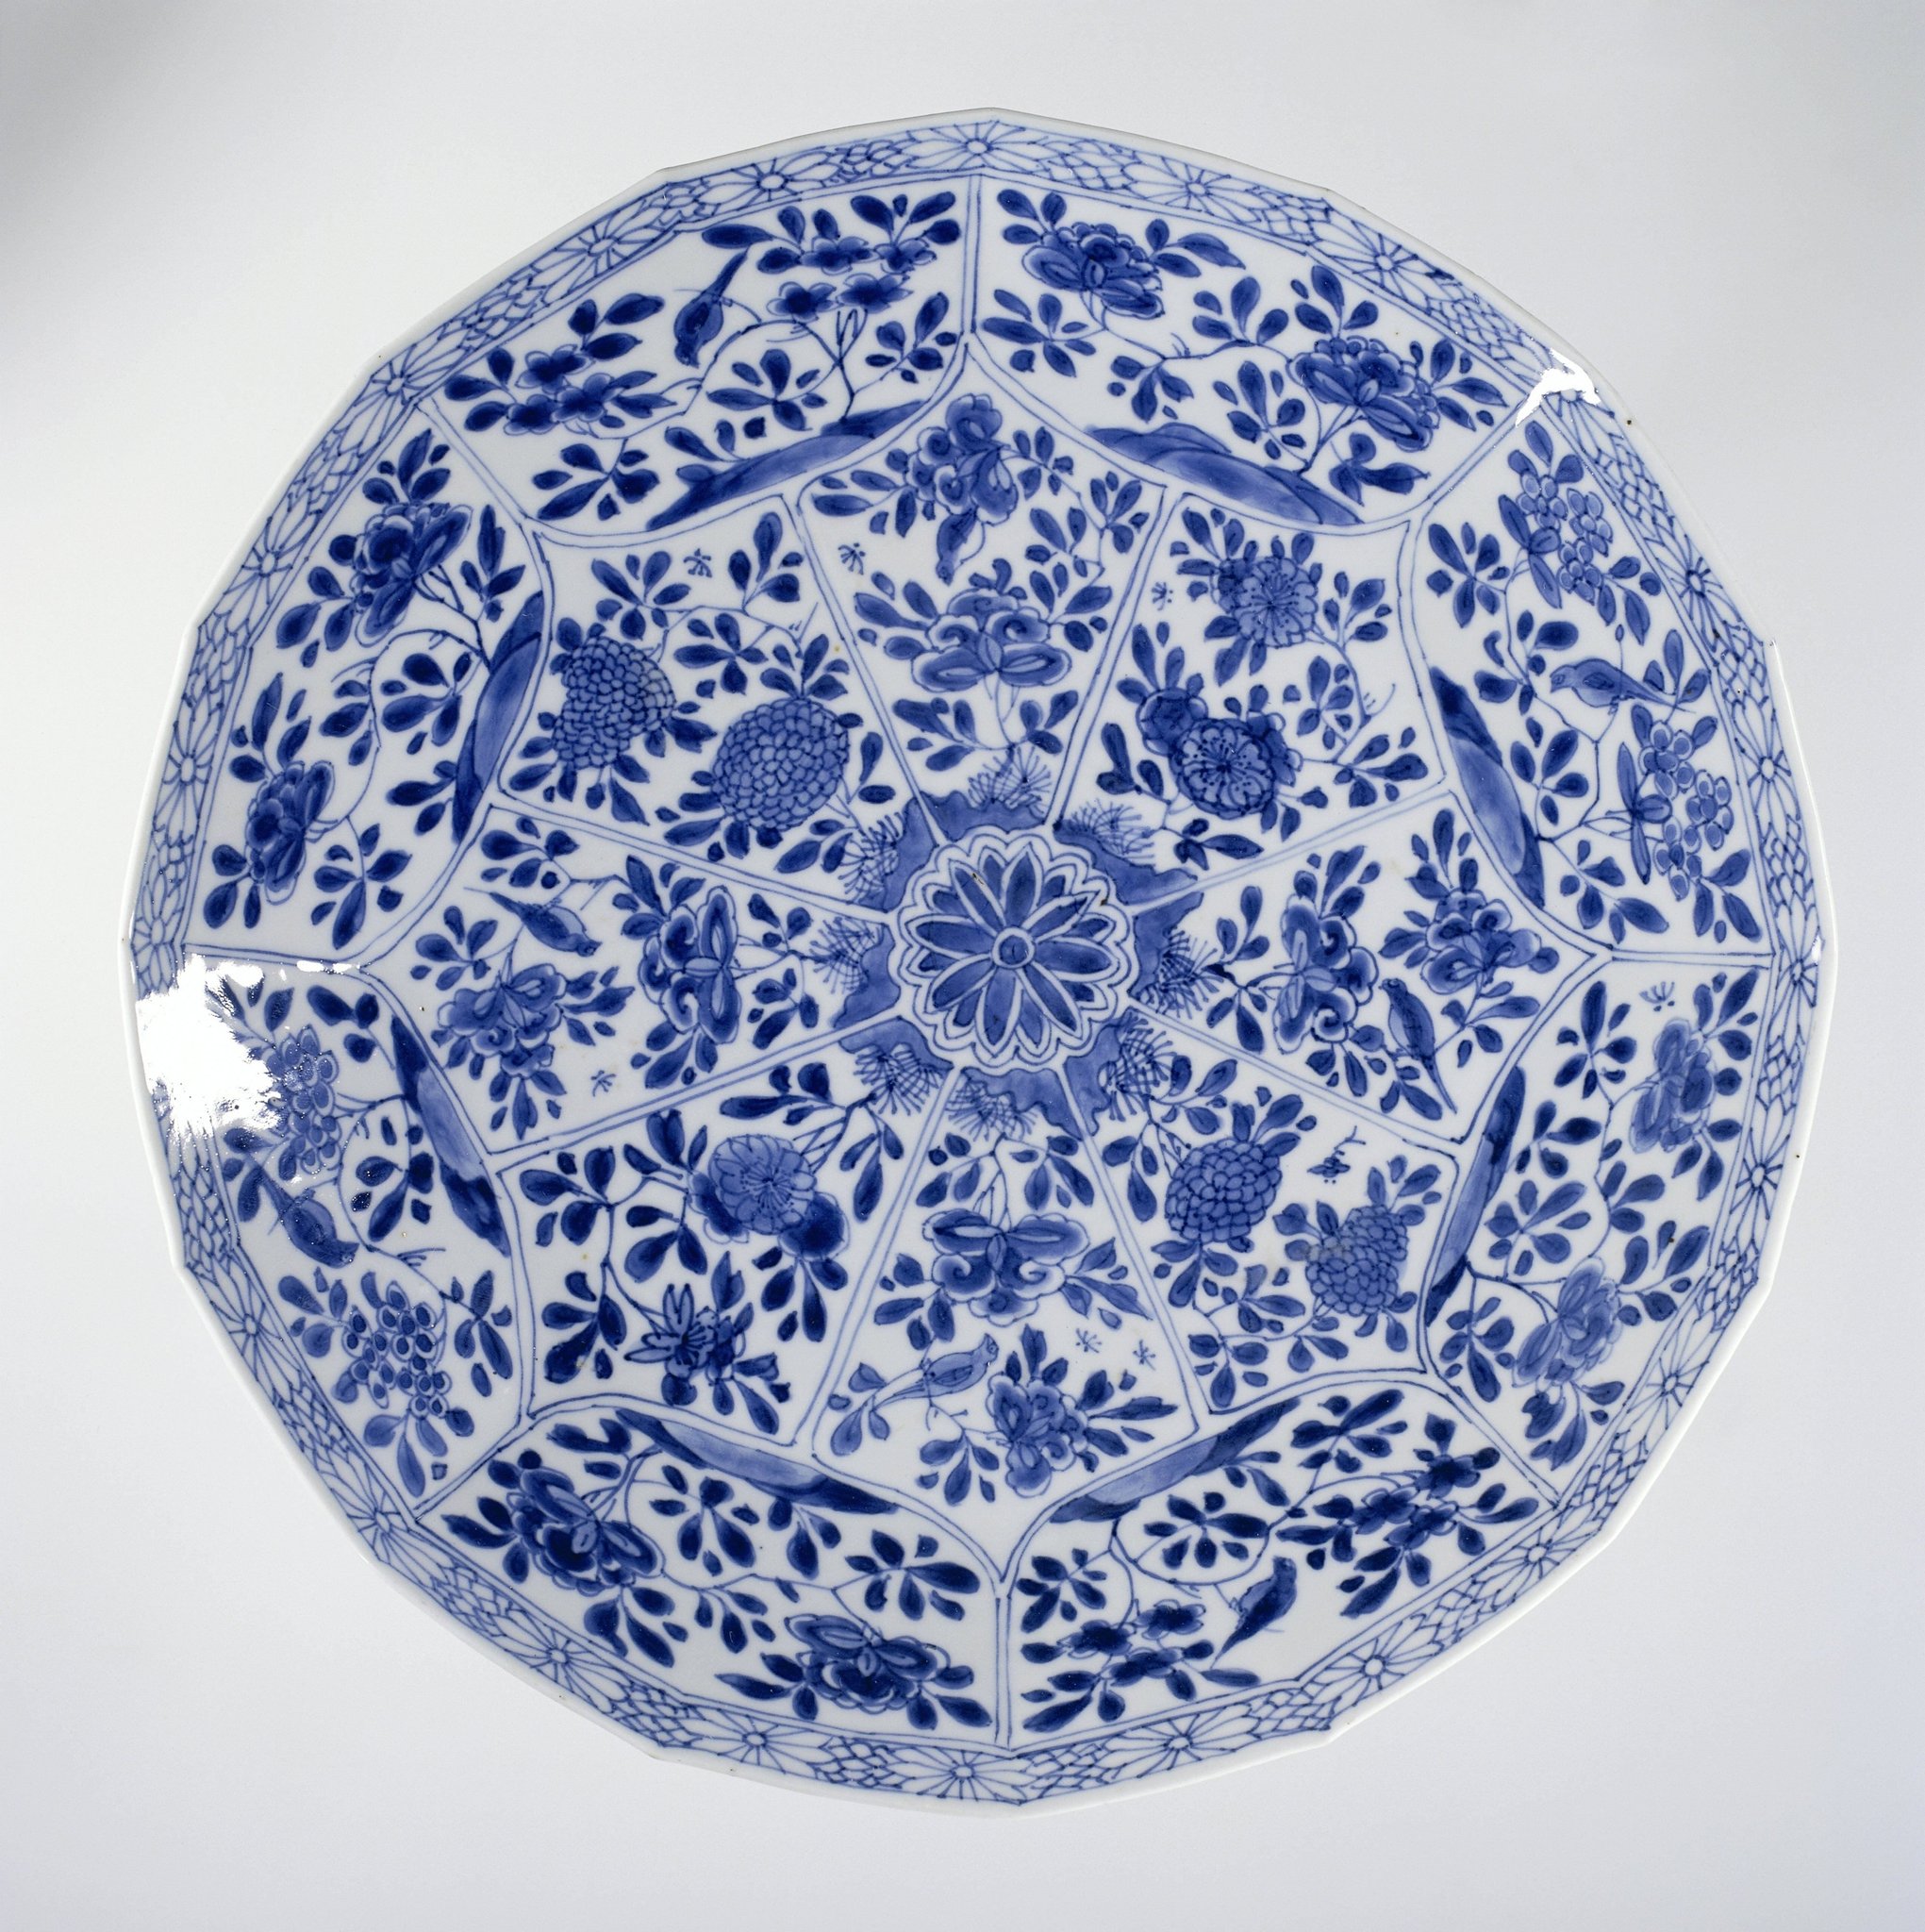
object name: dish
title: Saucer-dish with panel decoration with flower sprays and birds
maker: Anonymous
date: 1680-1720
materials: cobalt, glaze, paint, porcelain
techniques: firing, forming, turning, vitrification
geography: china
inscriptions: mark